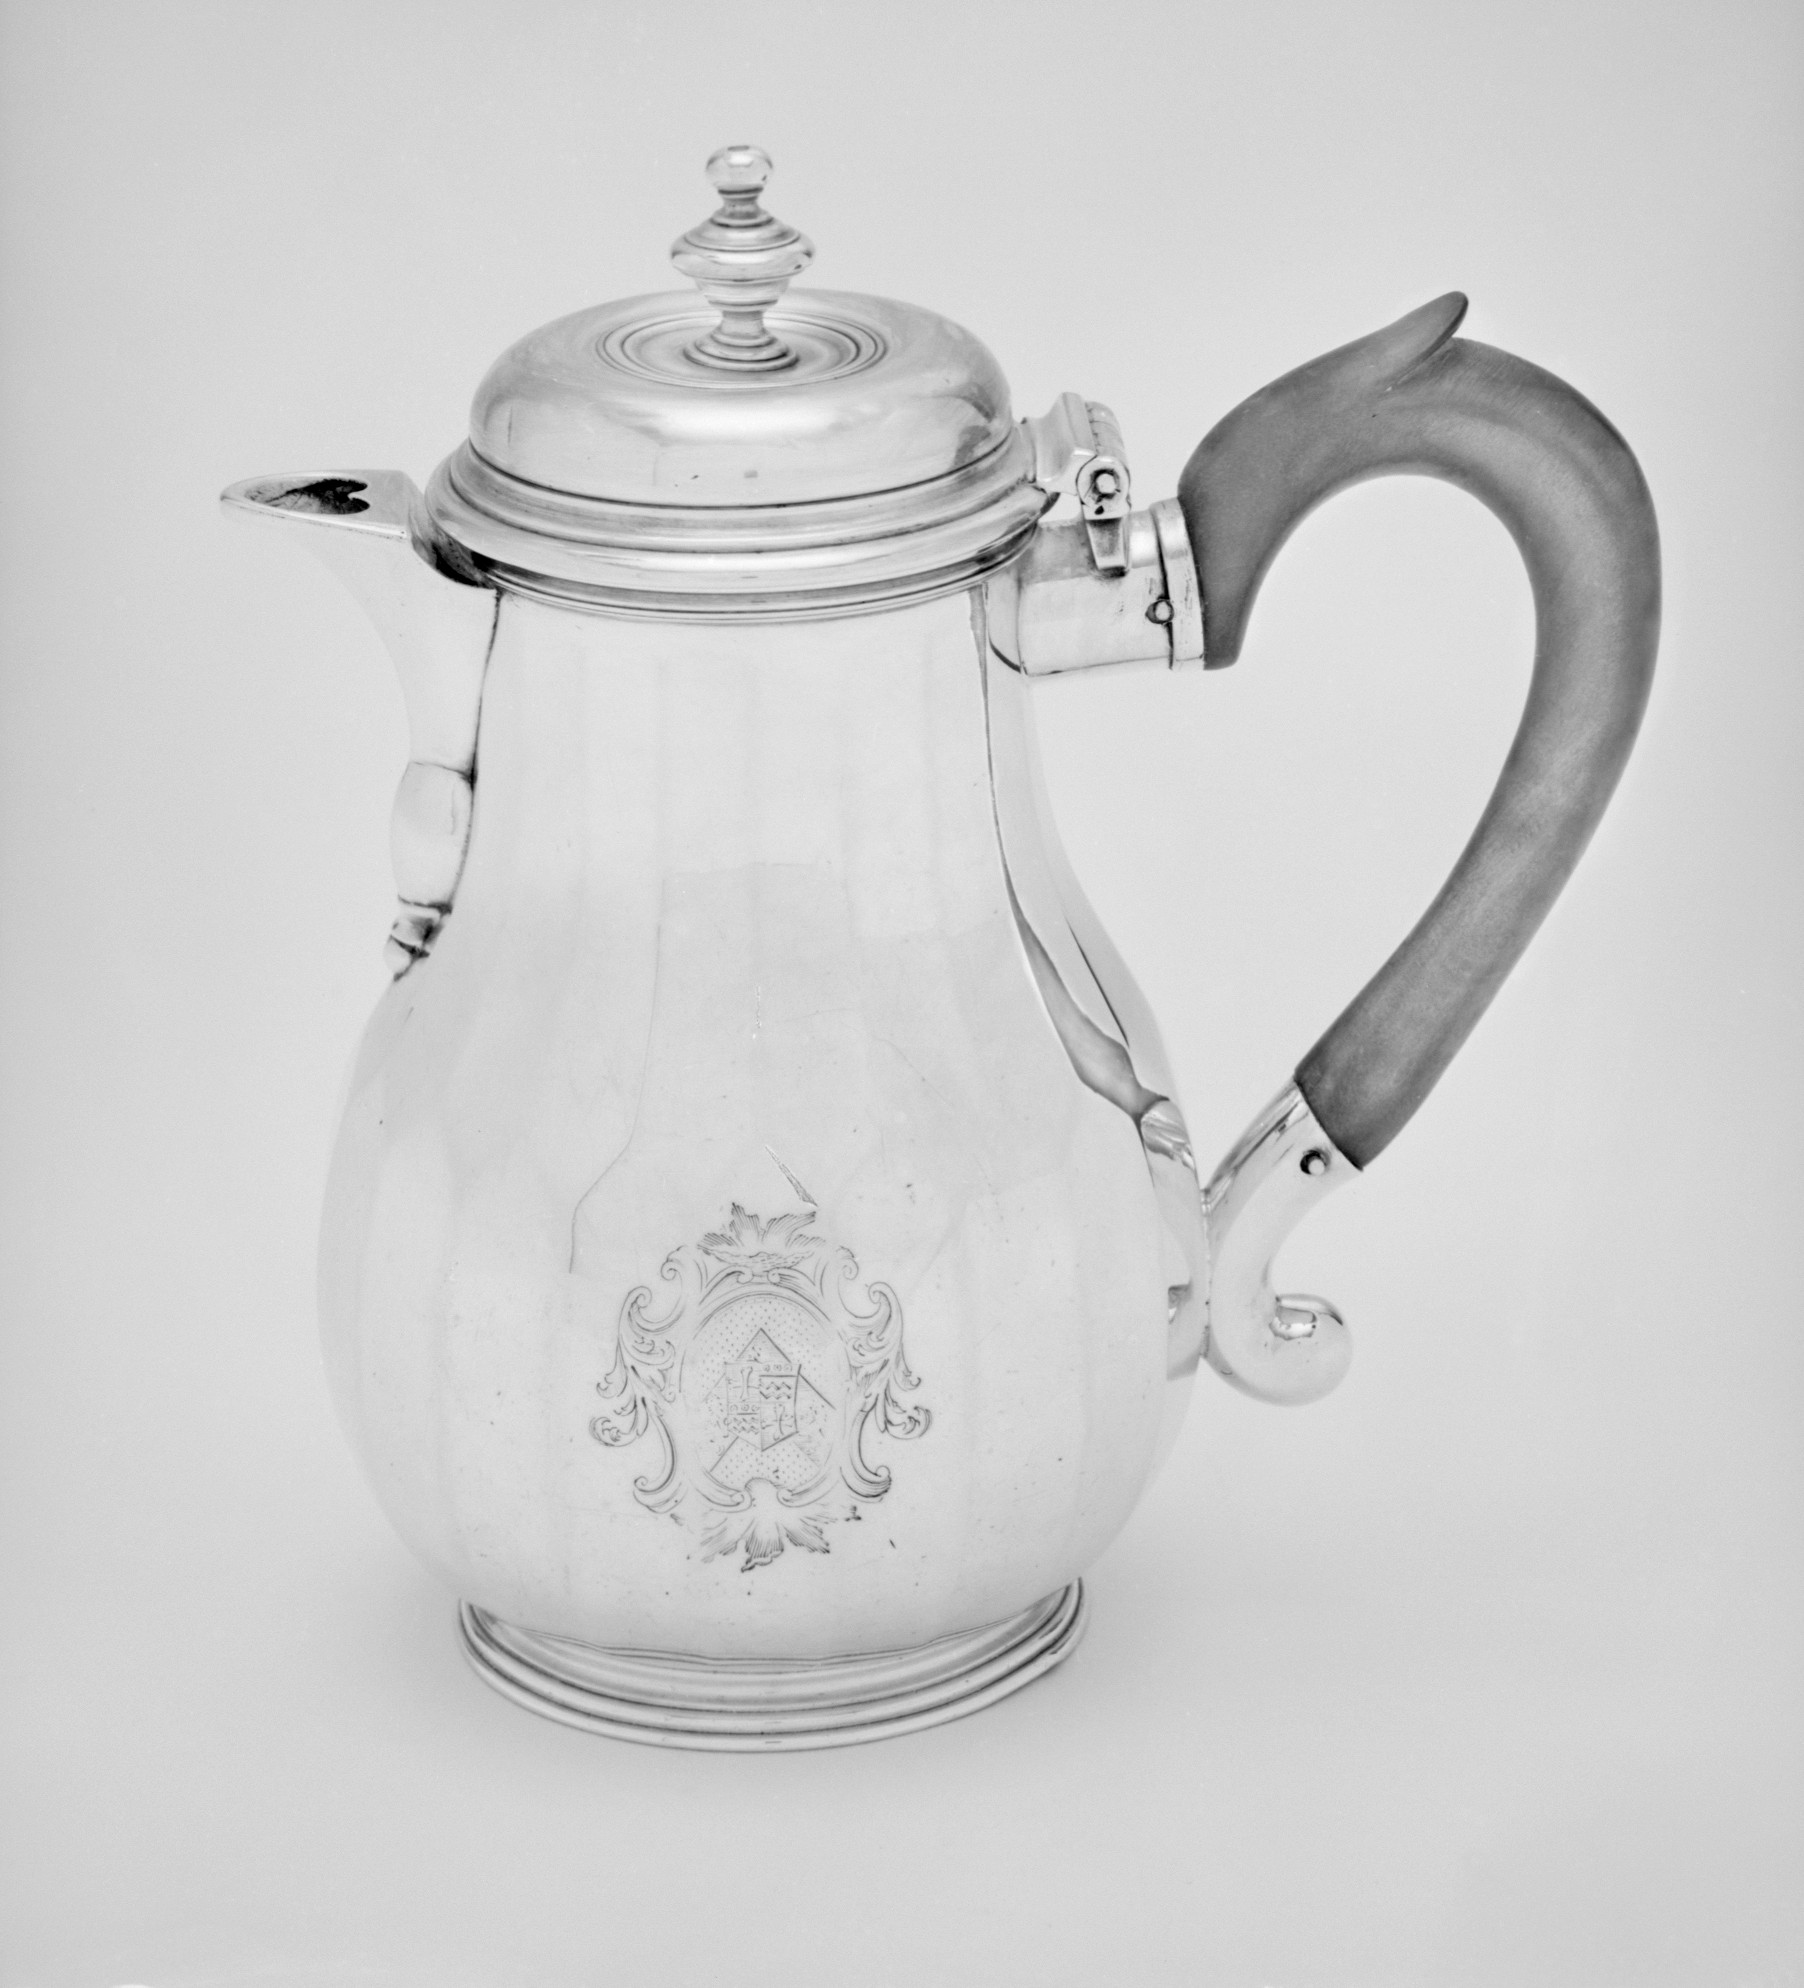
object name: jug with cover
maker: pezé pilleau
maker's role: maker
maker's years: 1709-1755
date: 1730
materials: silver, wood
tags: coat of arms